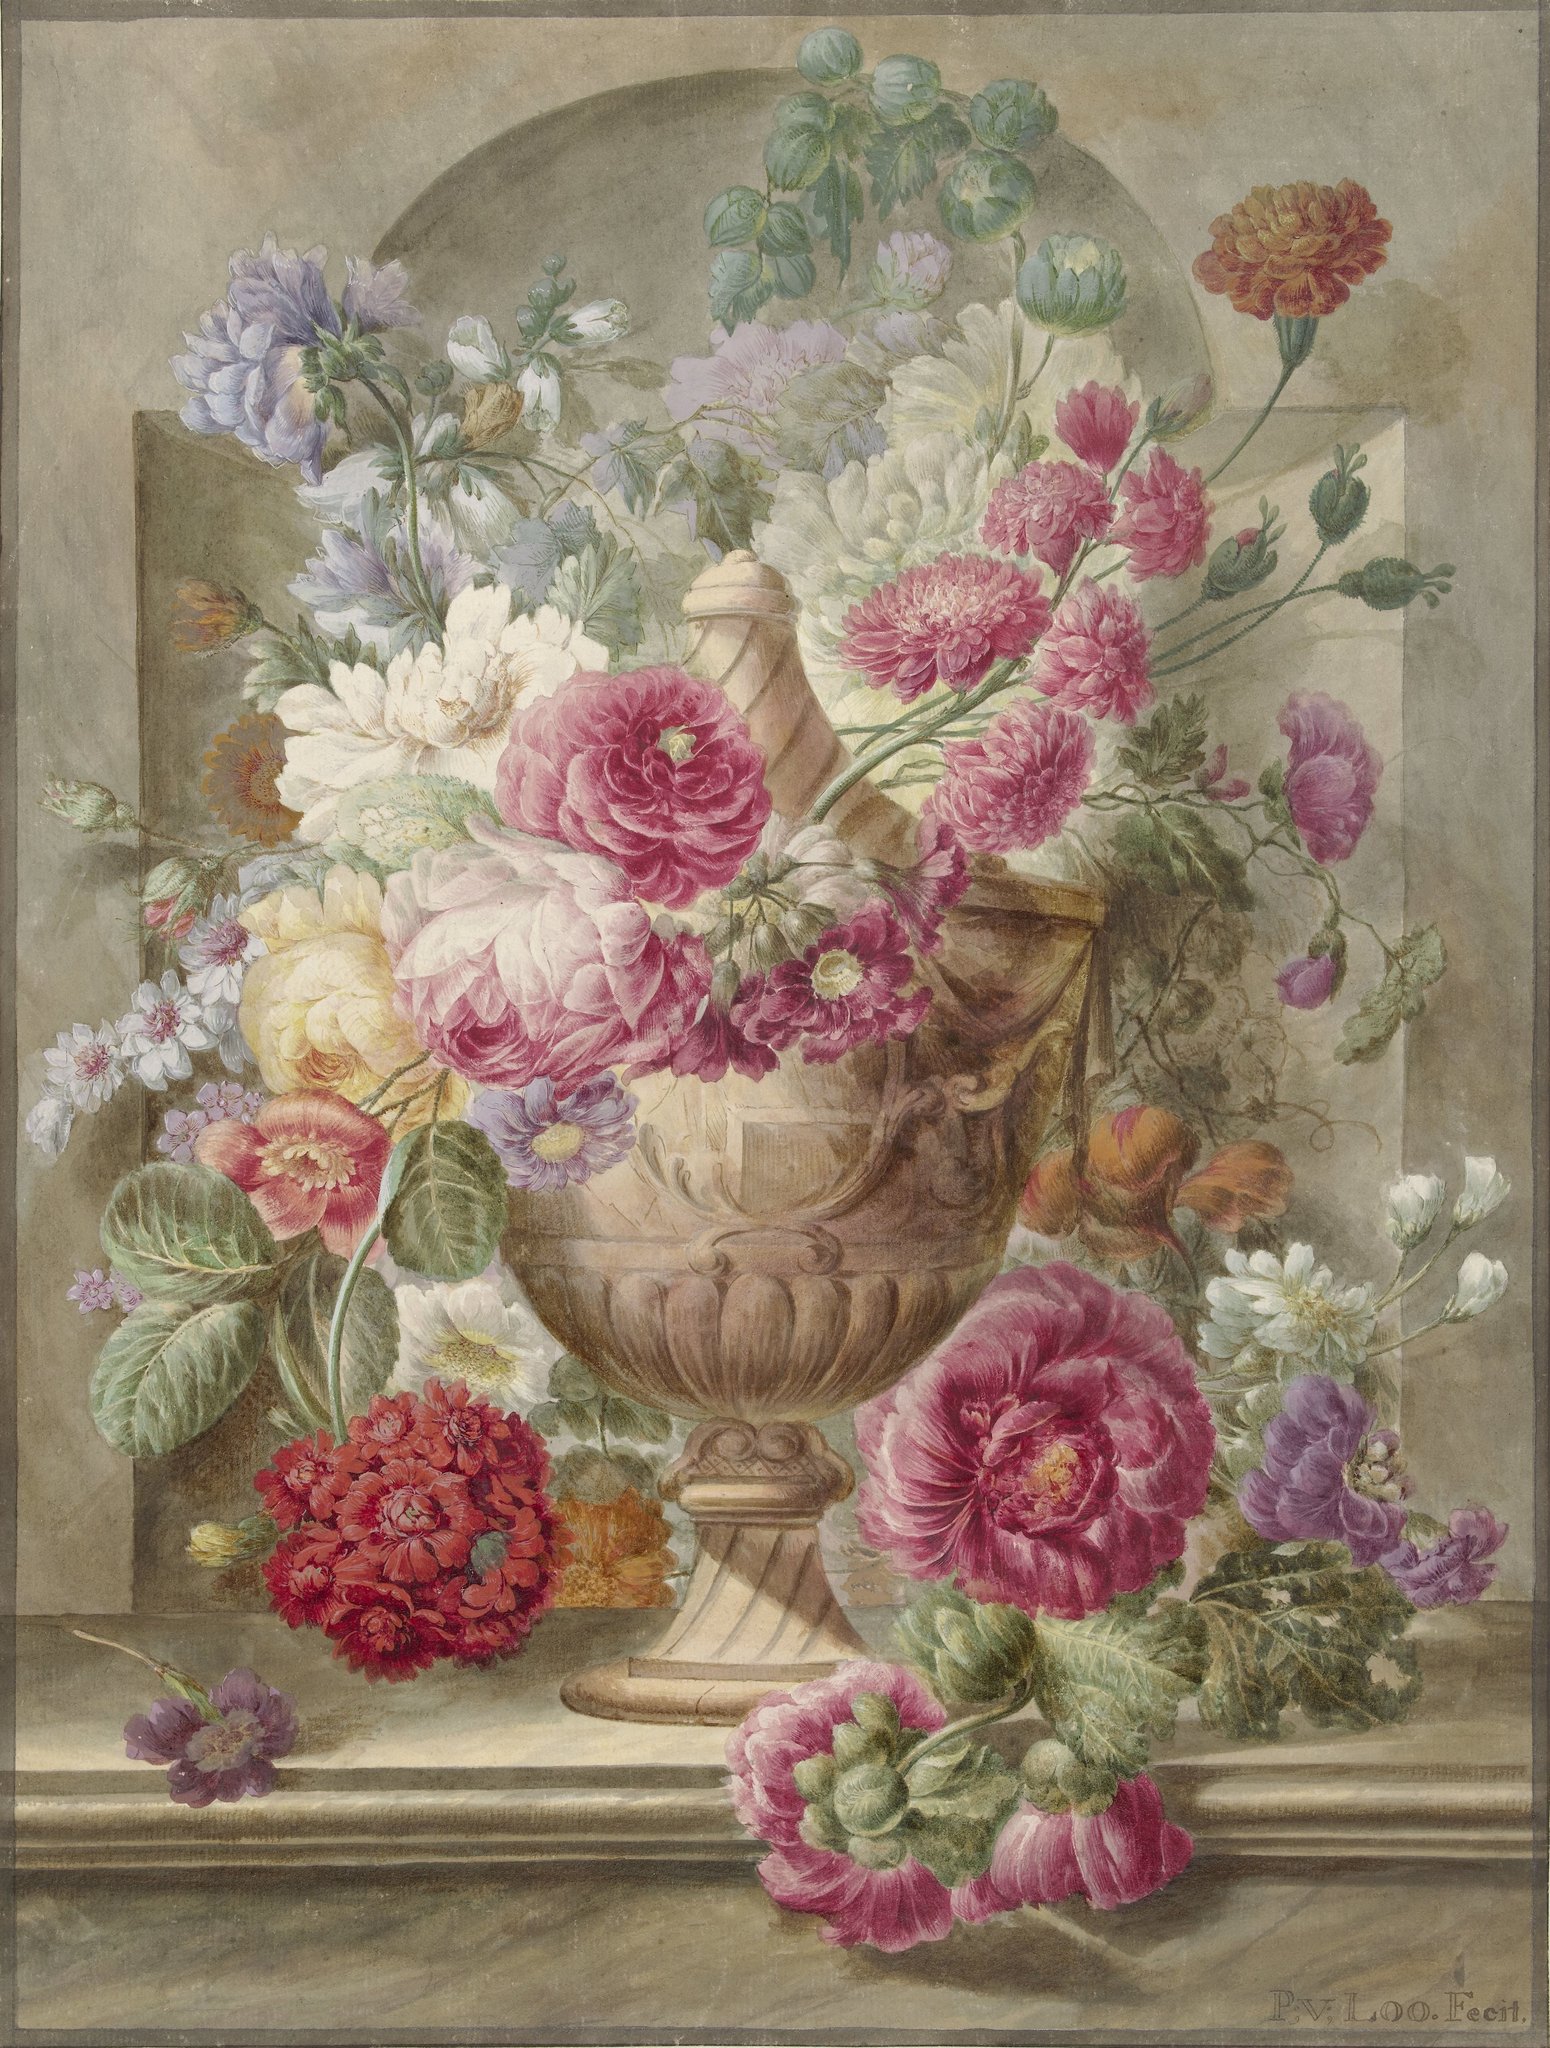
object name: drawing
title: Vaas met bloemen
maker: pieter van loo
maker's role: draughtsman, painter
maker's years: 1735-1784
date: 1745-1784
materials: paper, watercolor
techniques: brush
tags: flowers in a vase